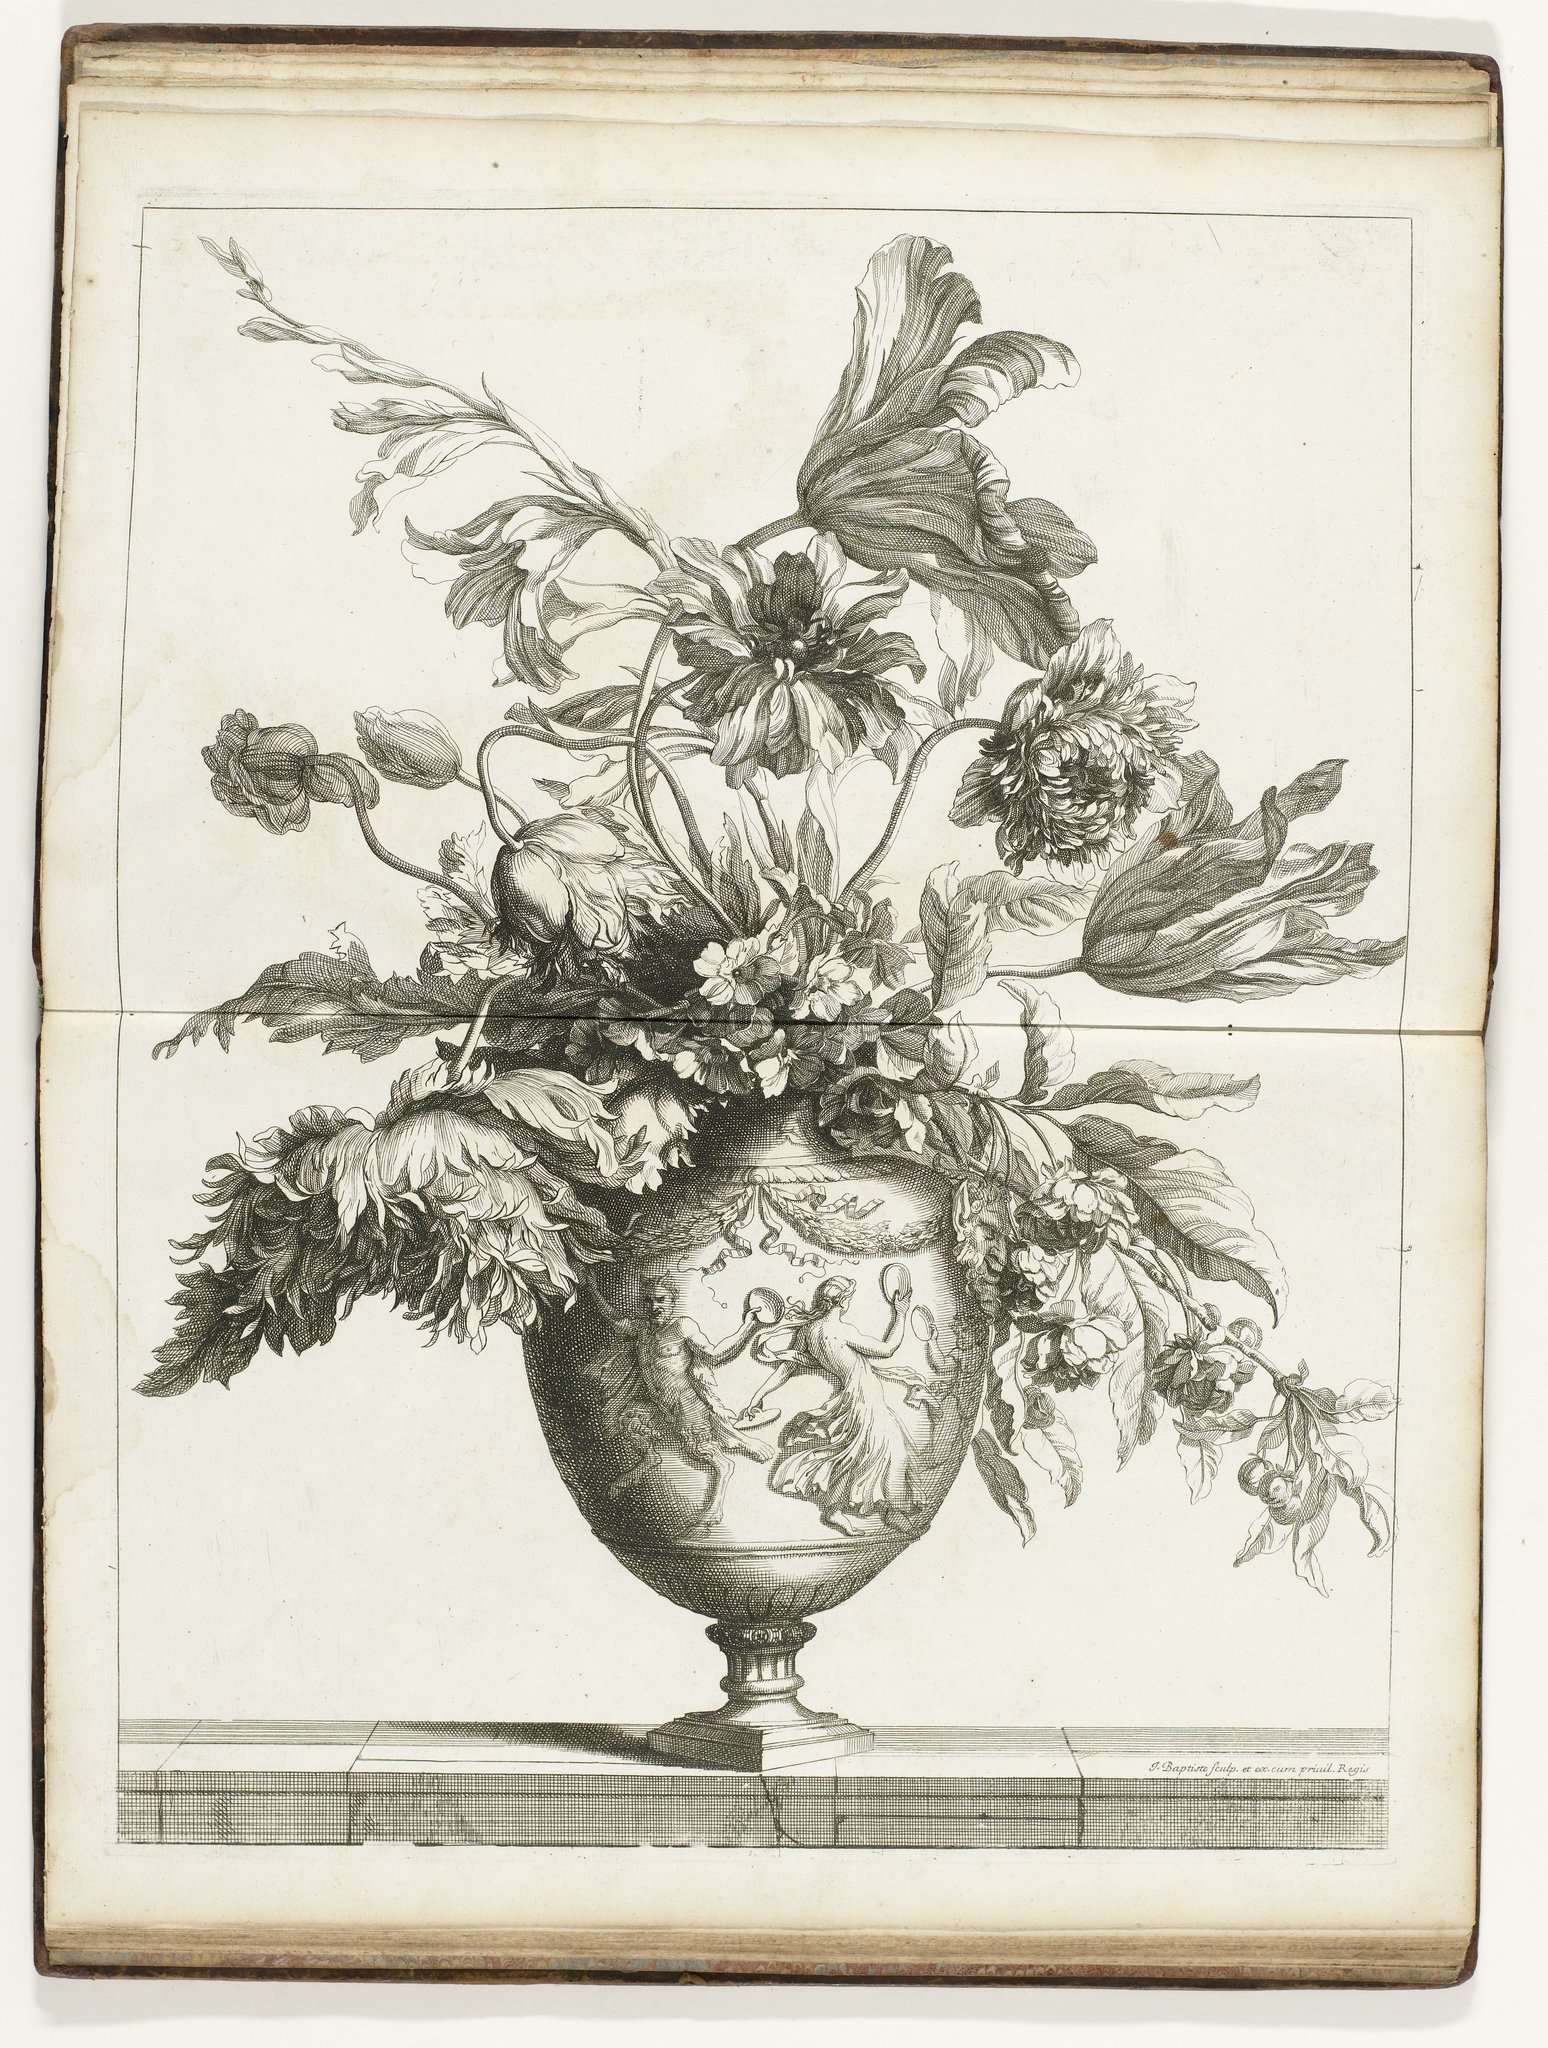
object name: album leaf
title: Bloemenvaas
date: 1680-1695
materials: paper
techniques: etching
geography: paris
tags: flowers in a vase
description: Bloemenvaas waarin bloemen. Prent maakt deel uit van een album.